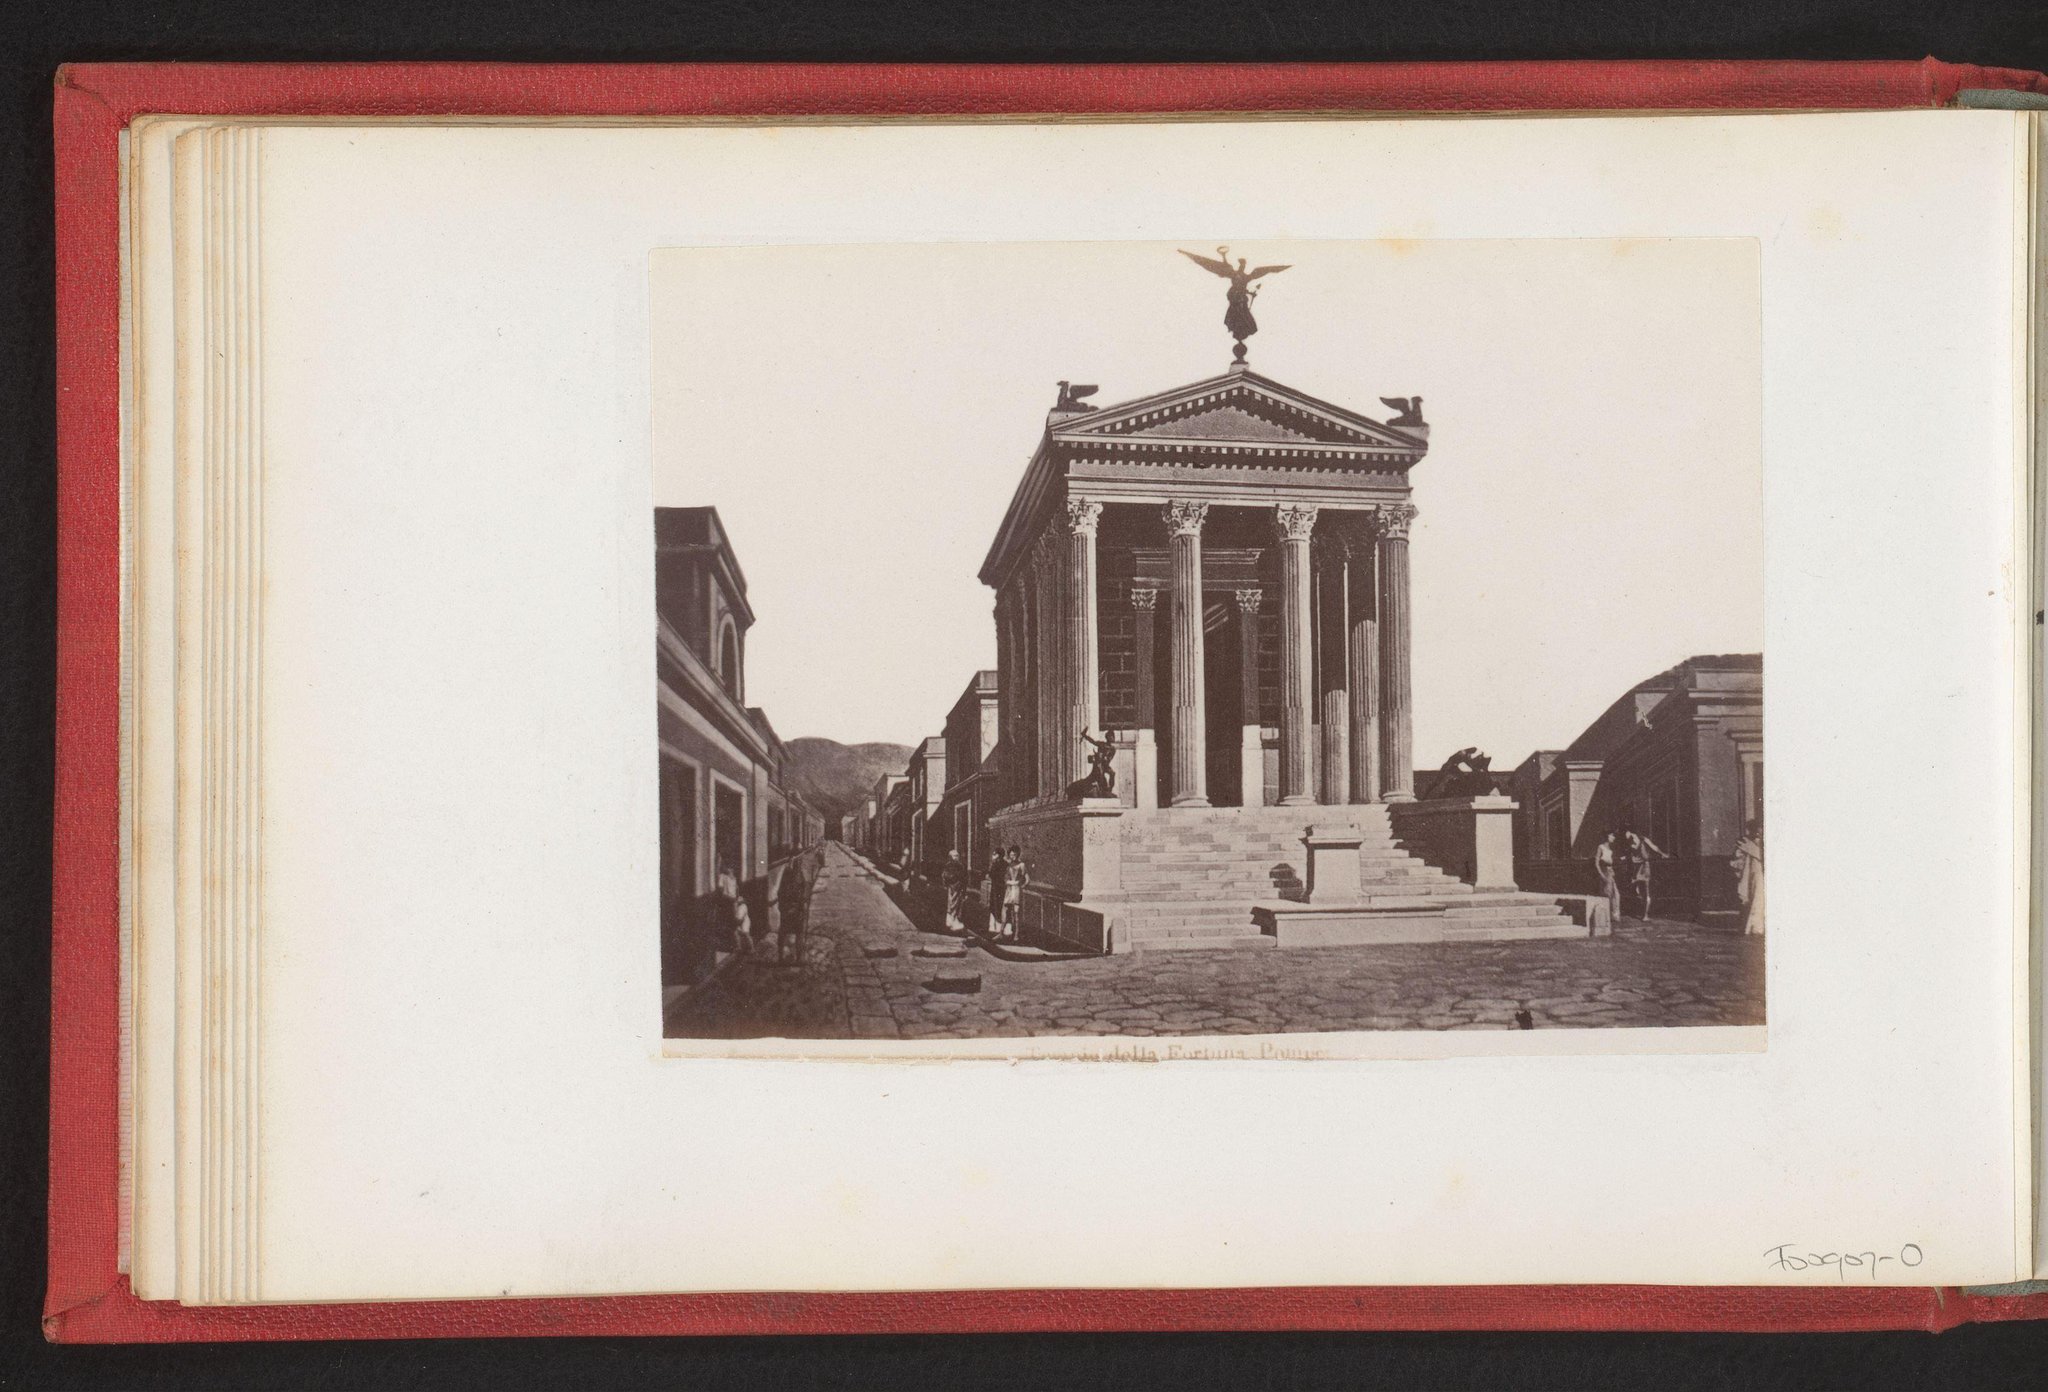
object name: album leaf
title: Tempio della Fortuna, Pompei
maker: Anonymous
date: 1860-1900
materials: photographic support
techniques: albumen print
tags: temple, shrine ~ roman religion, street